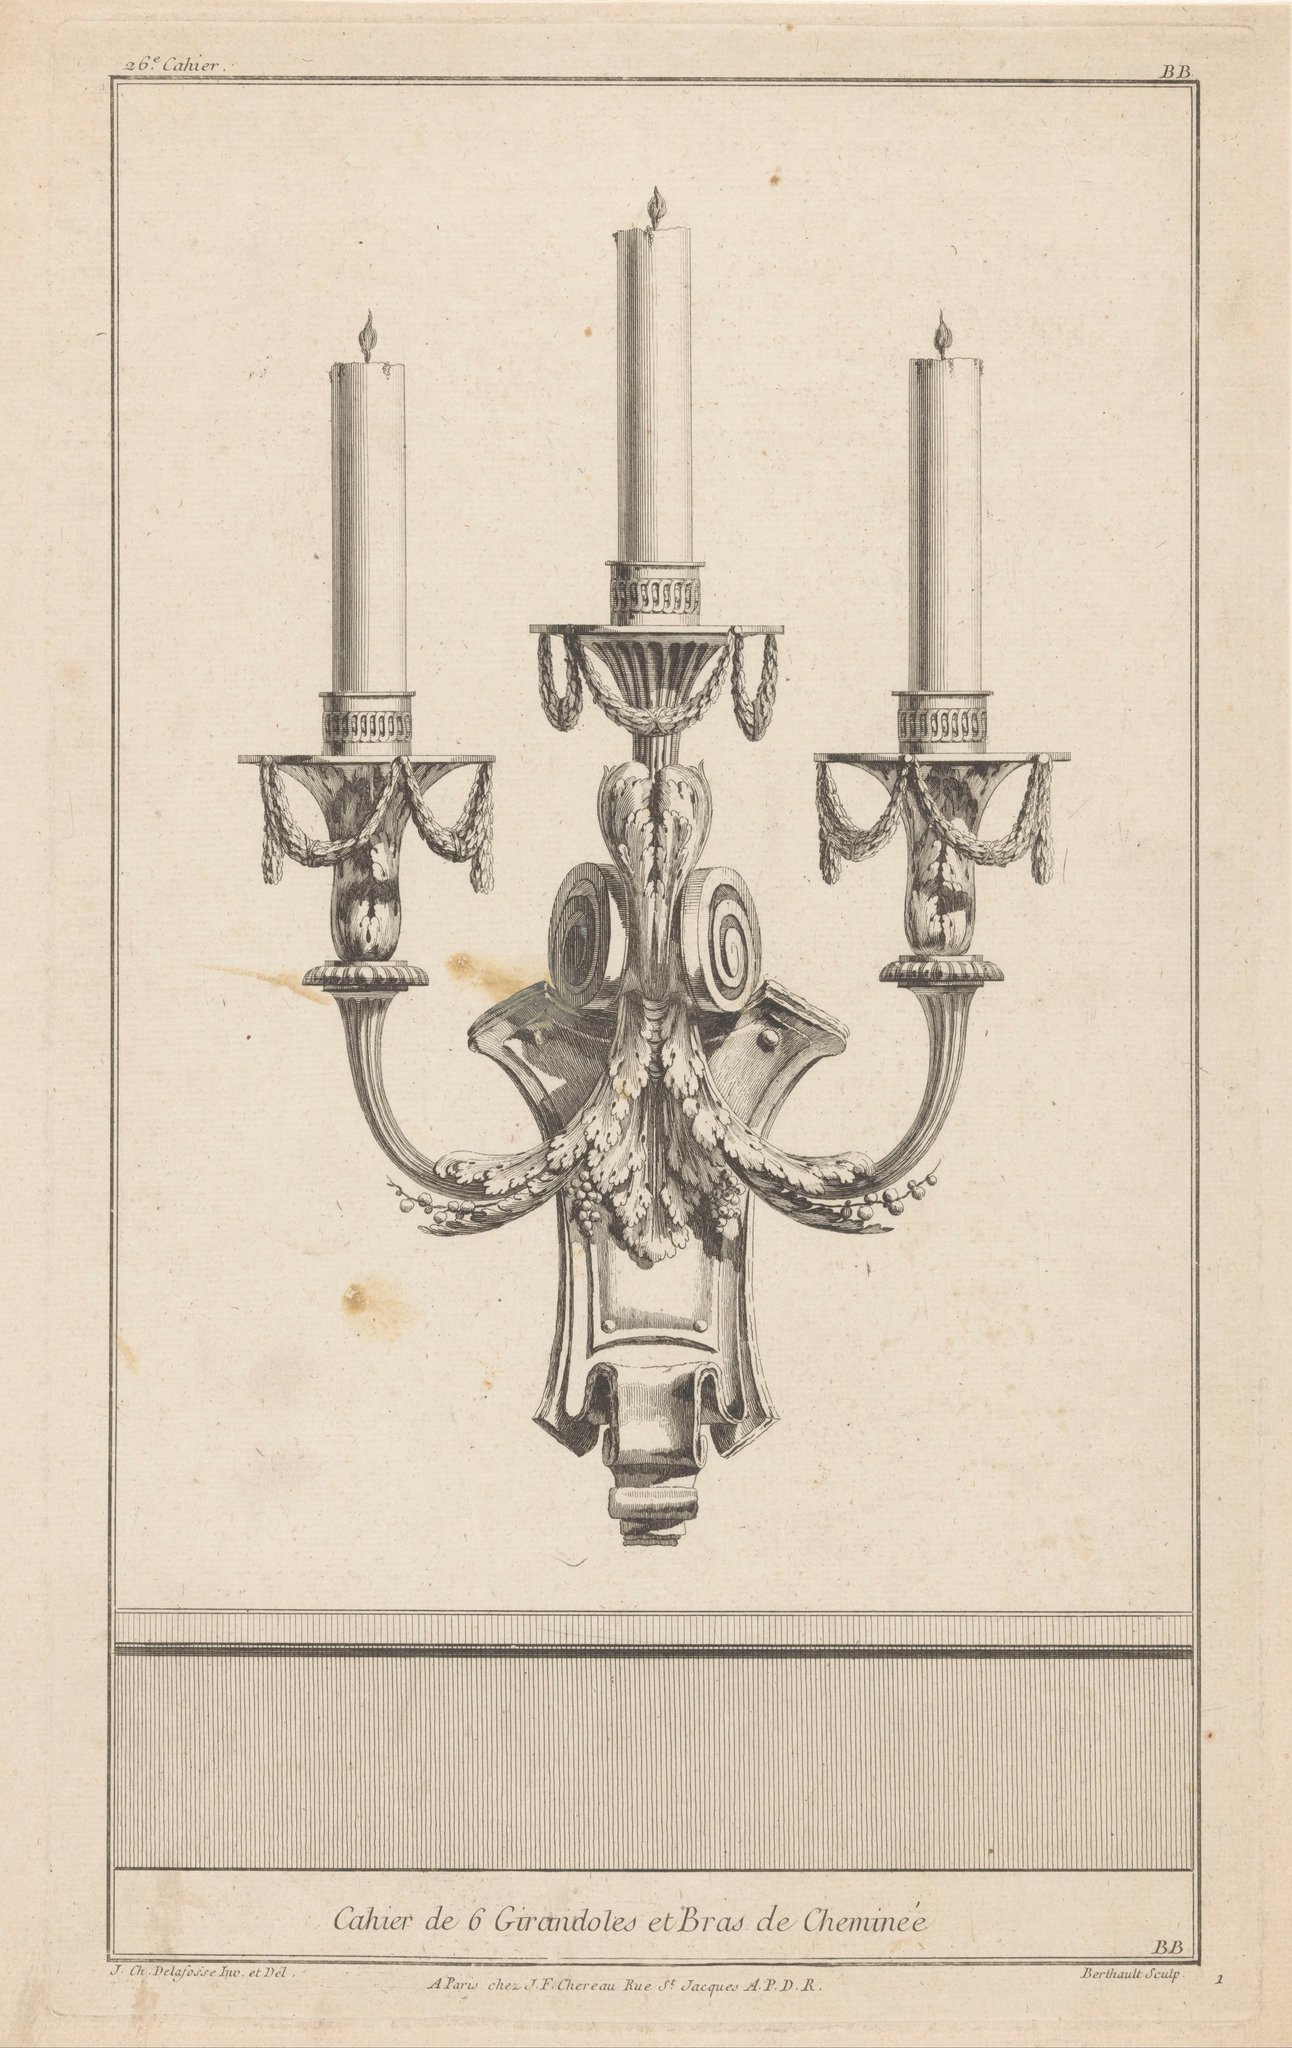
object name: print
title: Driearmige girandole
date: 1771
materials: paper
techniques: engraving, etching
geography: paris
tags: chandelier, candelabrum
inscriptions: collector's mark: Lugt 2228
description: Een geornamenteerde driearmige girandole.